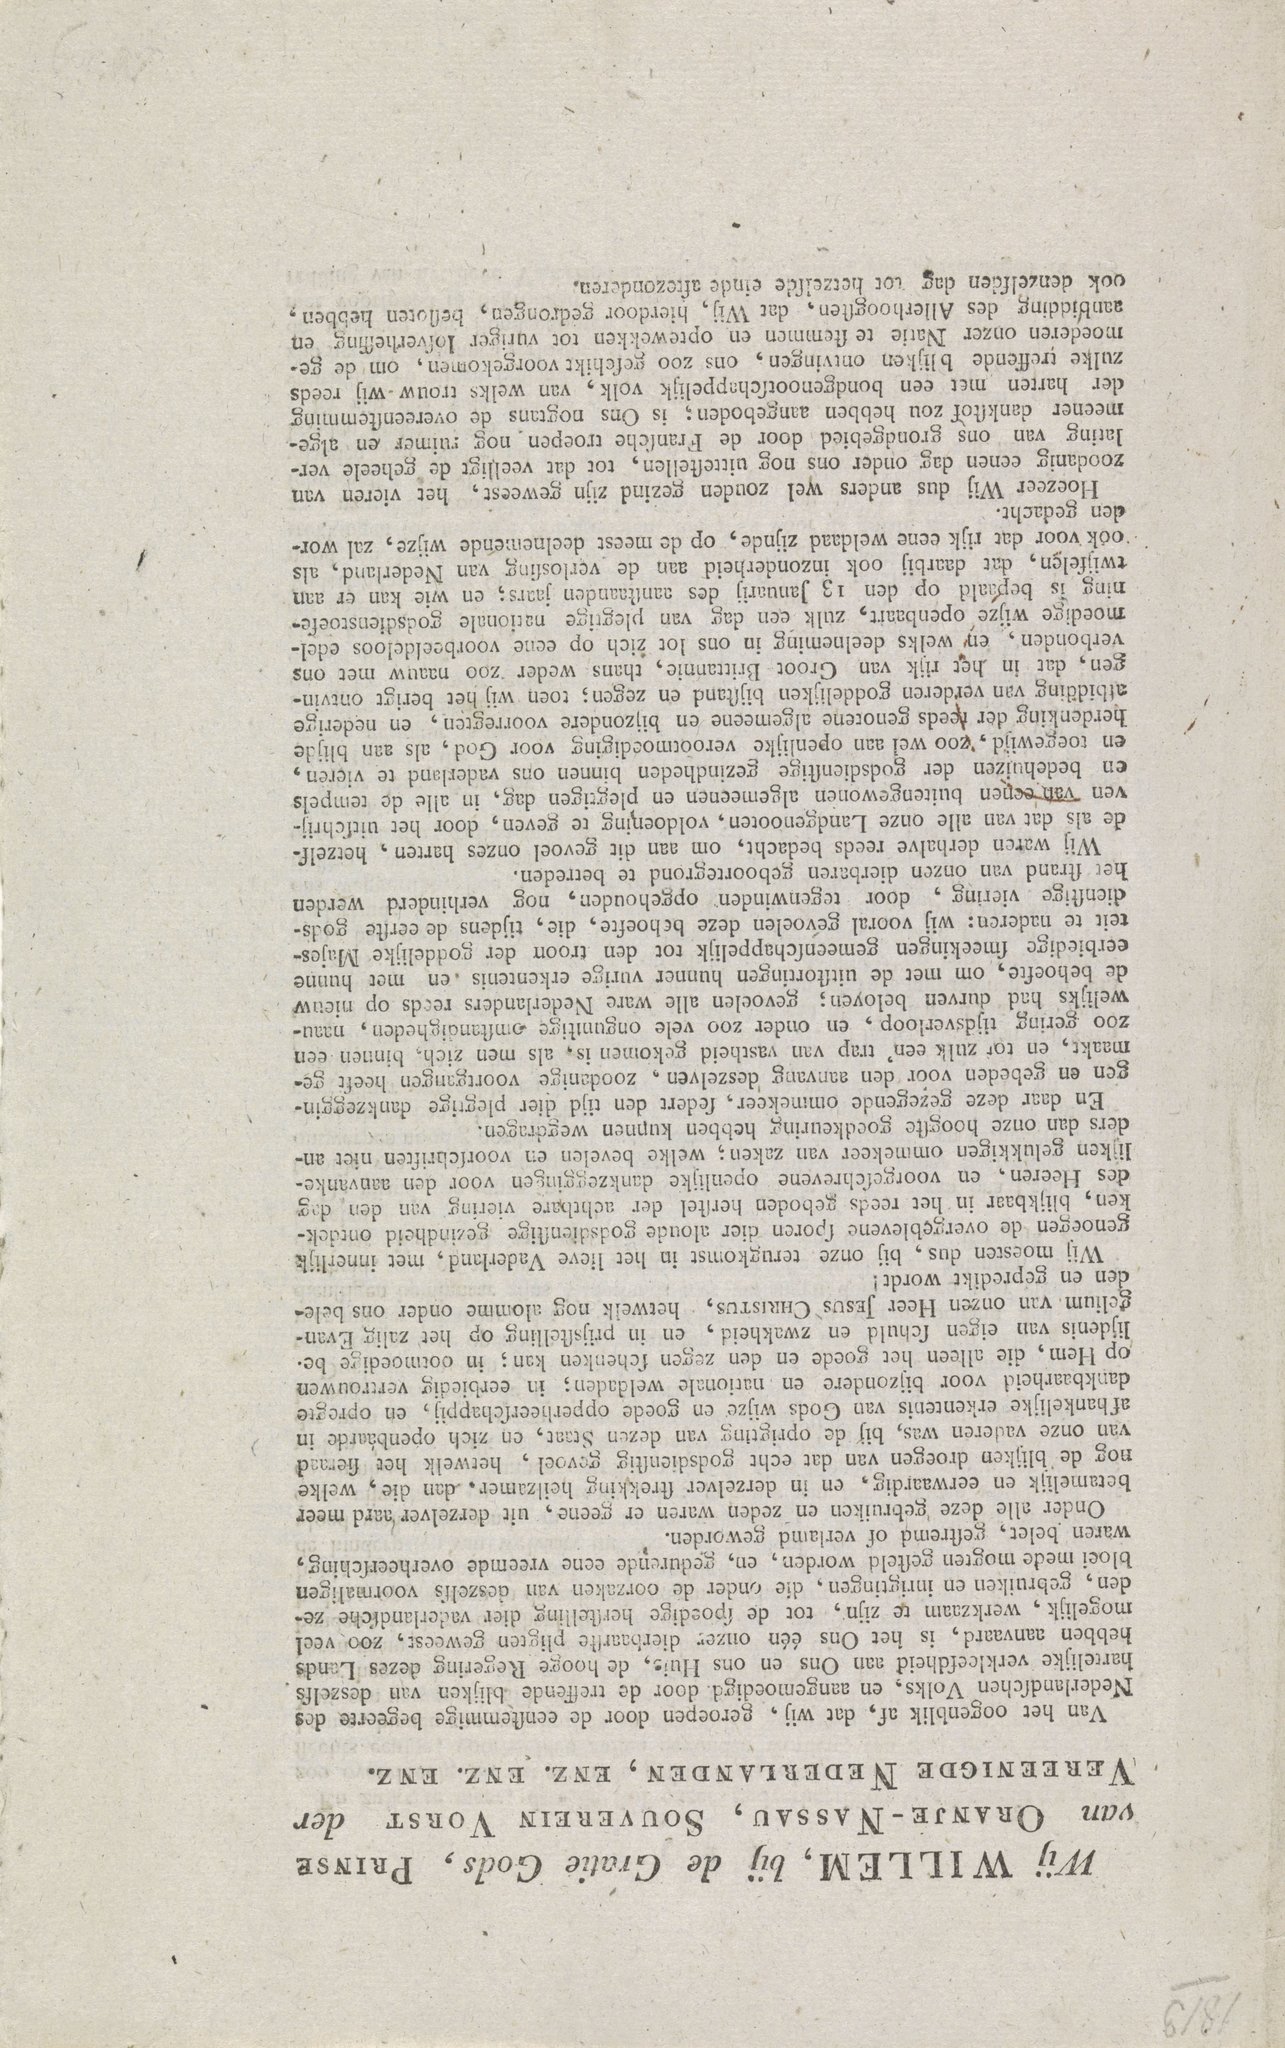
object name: text sheet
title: Uitschrijving van een algemene Dank-, Vast- en Bededag op 13 januari 1814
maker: anton reinhard falck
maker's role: minister van koloniën, minister van nijverheid, minister van onderwijs, advocaat, secretaris-generaal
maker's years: 1777-1843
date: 1801-1814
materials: paper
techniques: letterpress printing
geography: netherlands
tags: the hague, william i of the netherlands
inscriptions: collector's mark: Lugt 2166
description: Bekendmaking van de uitschrijving namens Willem Frederik, prins van Oranje als souverein vorst van een algemene Dank-, Vast- en Bededag te houden op 13 januari 1814. Dubbelgevouwen blad bedrukt op drie zijden. Tekst namens Willem I en A.R. Falck.